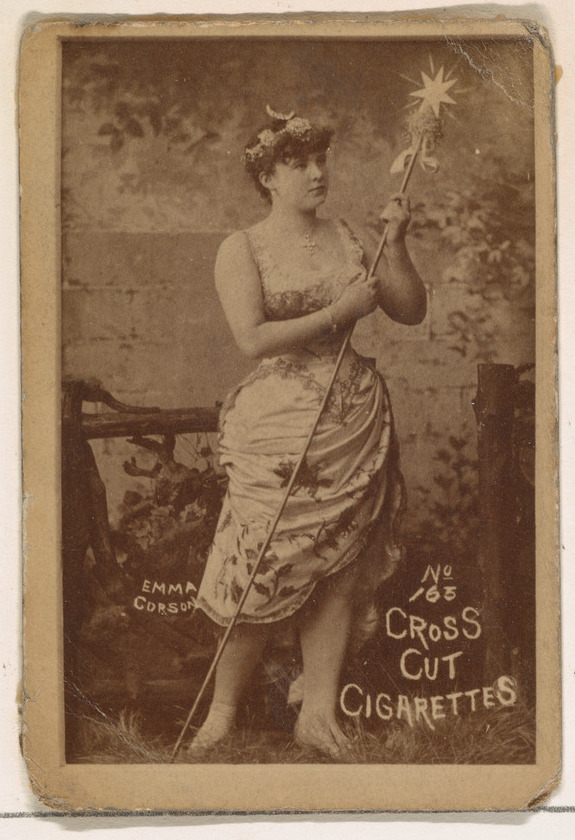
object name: print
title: Card Number 165, Emma Corson, from the Actors and Actresses series (N145-1) issued by Duke Sons & Co. to promote Cross Cut Cigarettes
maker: w. duke, sons & co.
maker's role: publisher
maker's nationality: american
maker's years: 1870-1920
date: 1880-1889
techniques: albumen silver print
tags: portraits,women,actresses